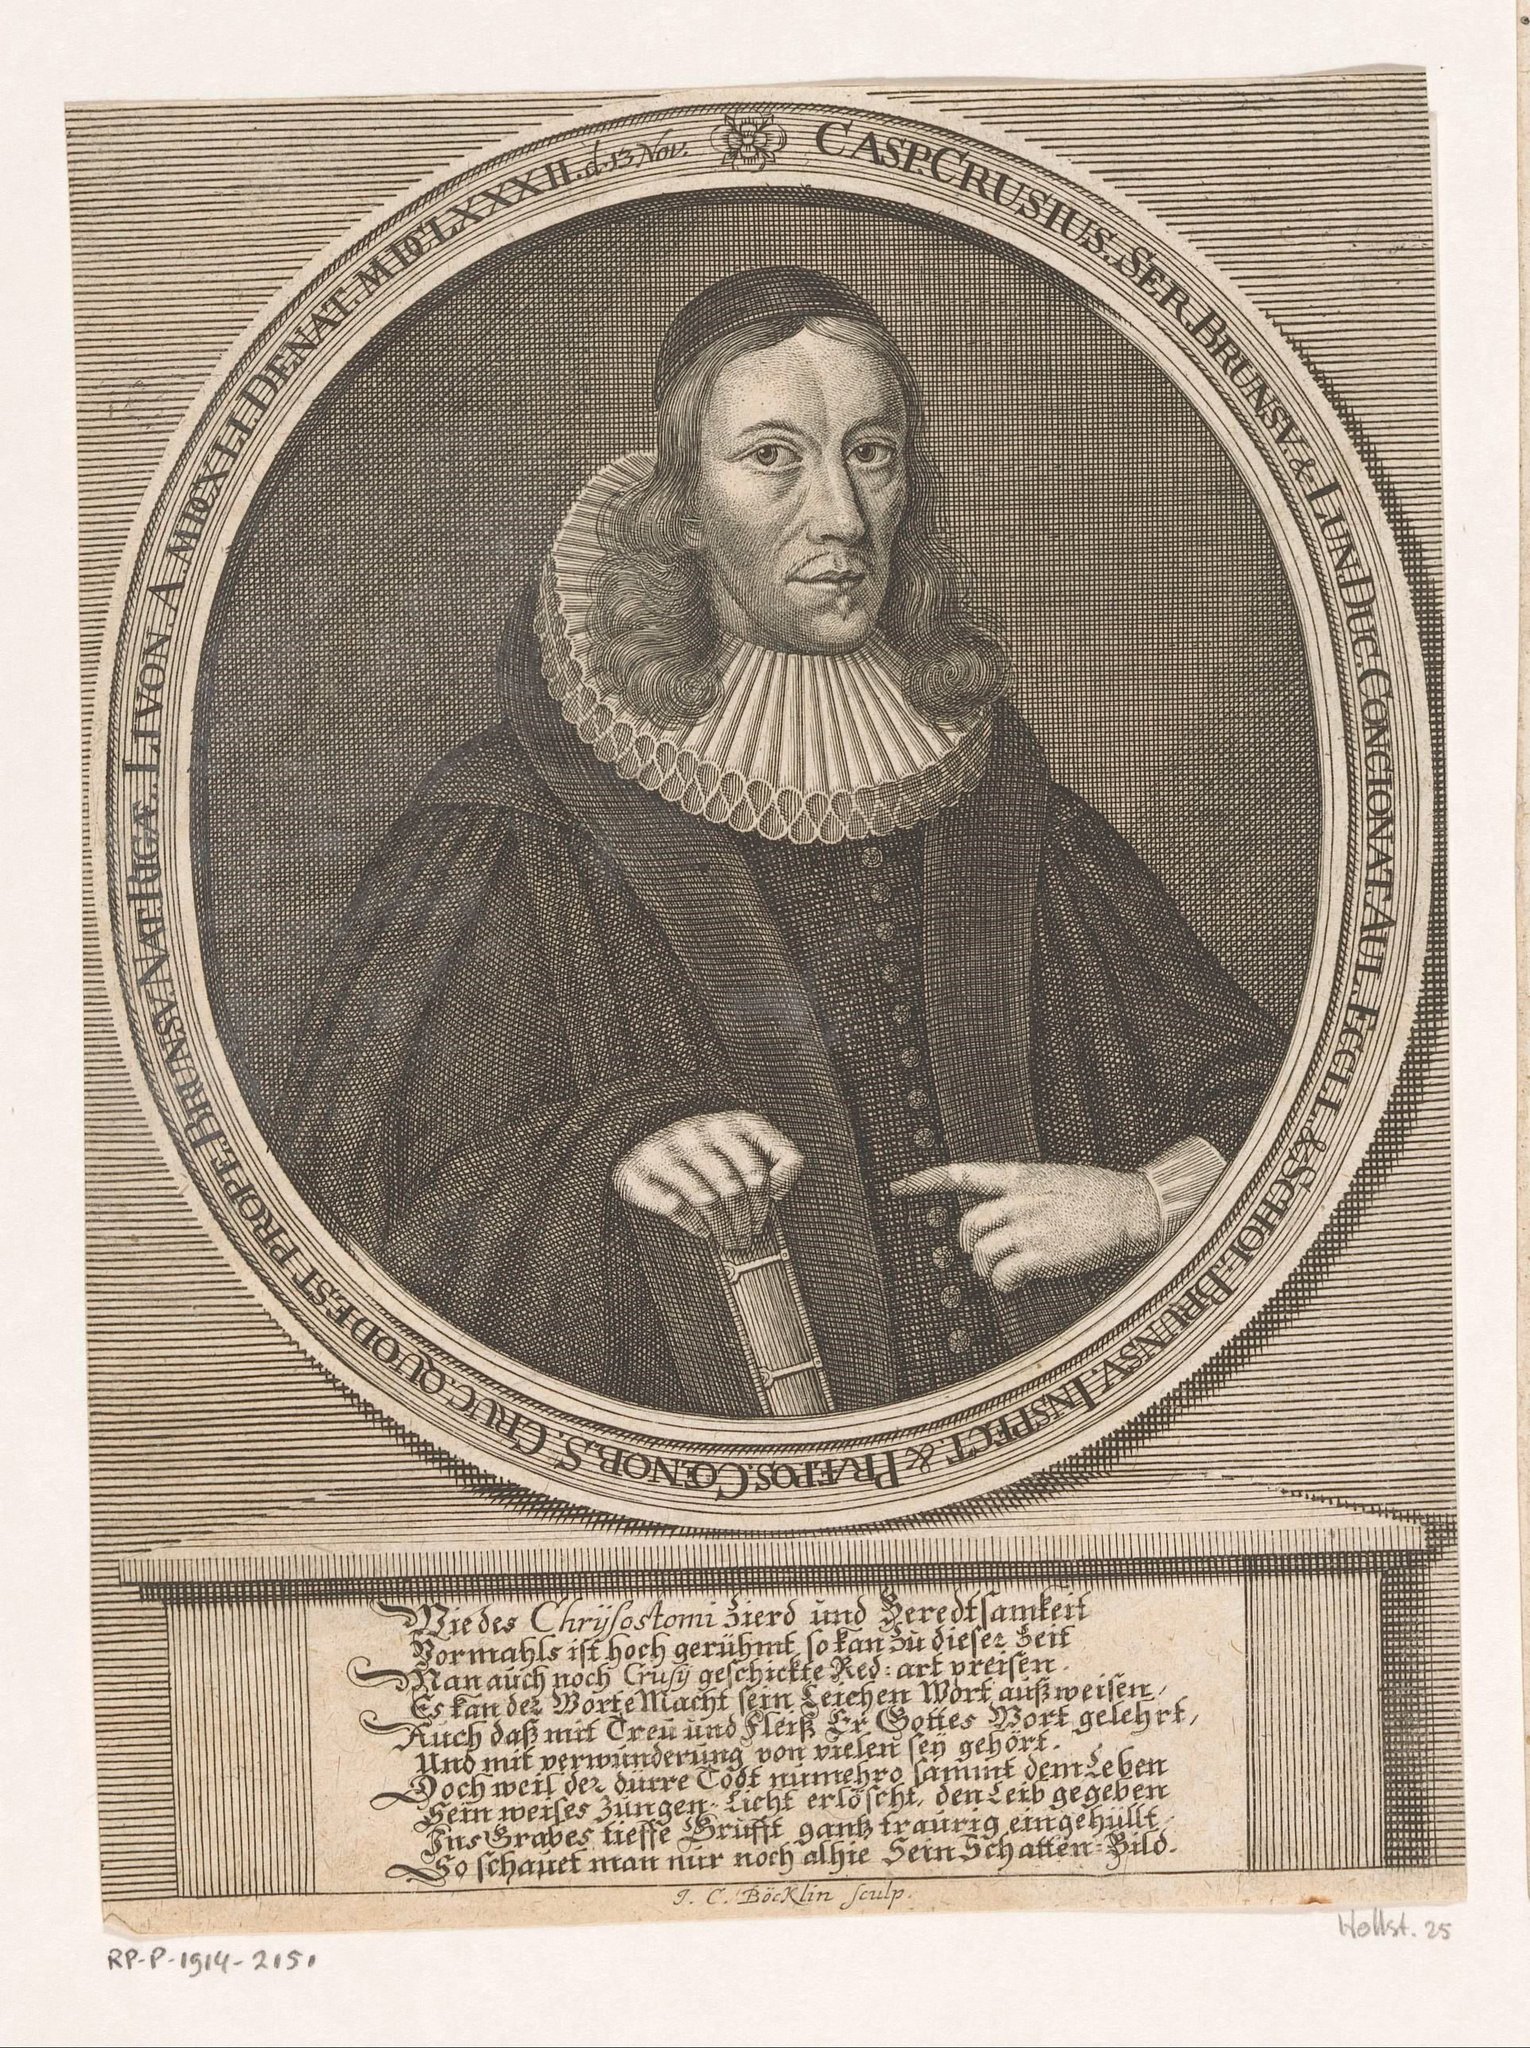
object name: print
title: Portret van Caspar Crusius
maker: johann christoph boecklin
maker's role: print maker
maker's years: 1657-1709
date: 1667-1709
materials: paper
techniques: engraving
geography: leipzig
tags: historical persons, book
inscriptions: collector's mark: Lugt 2228